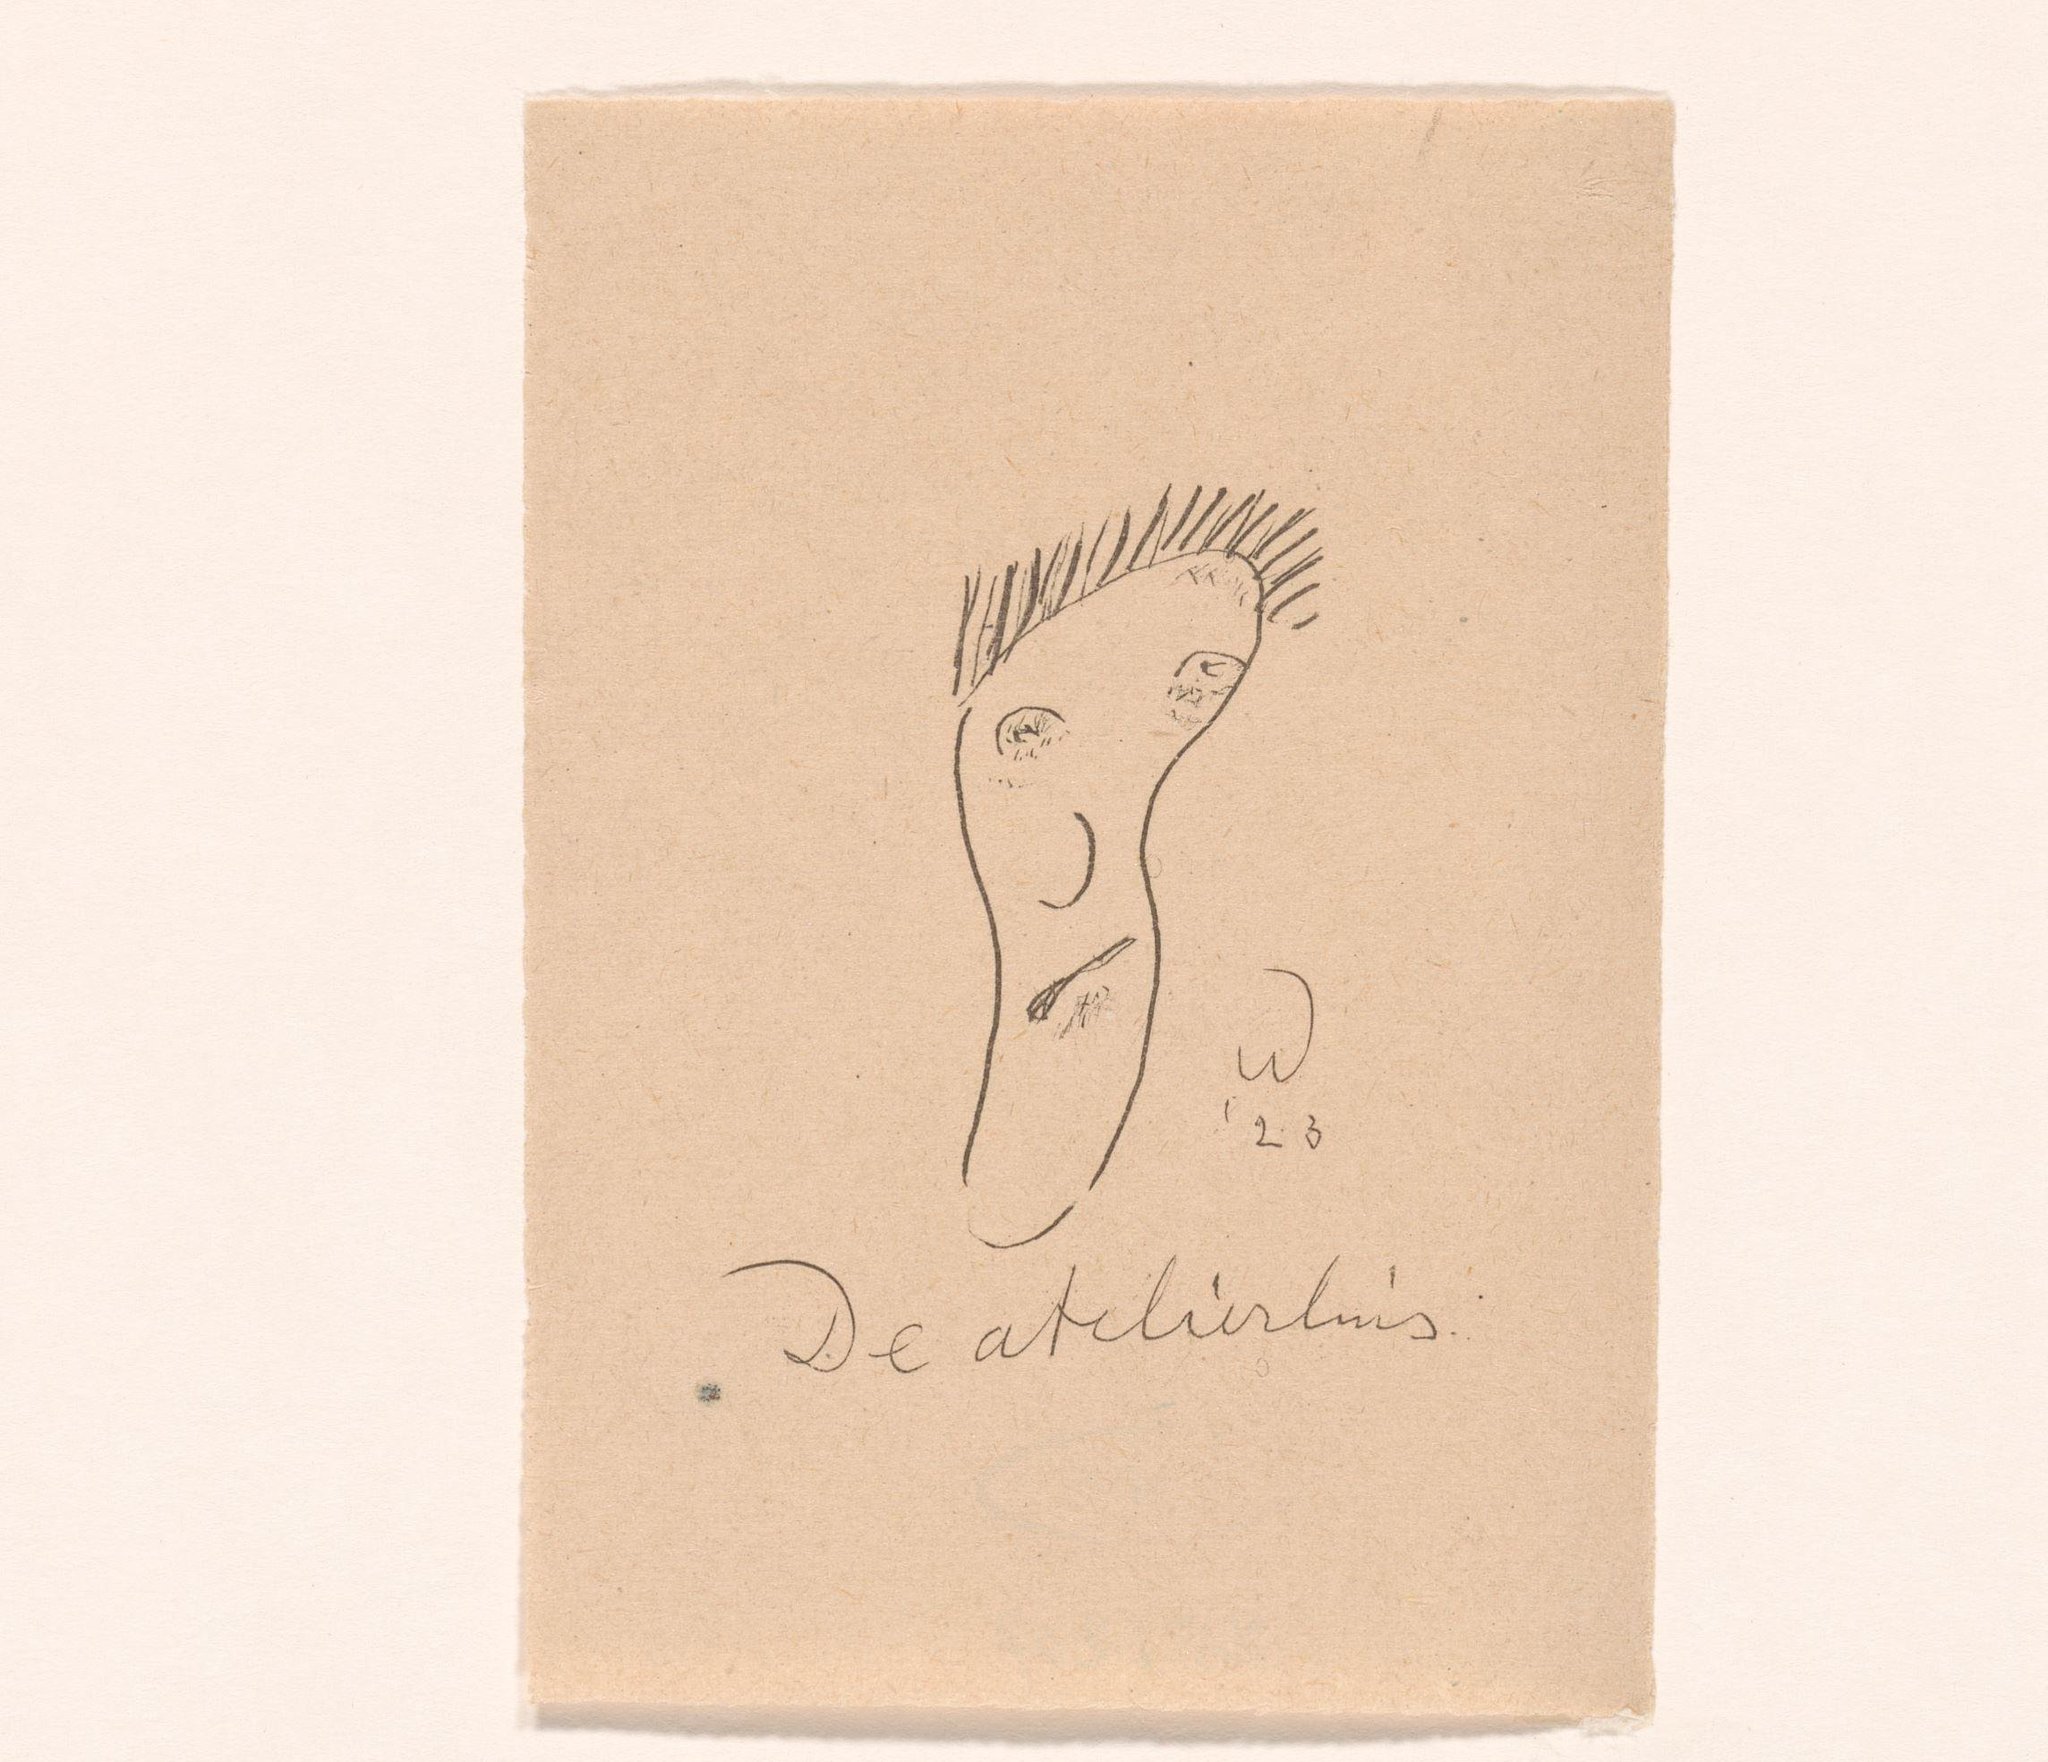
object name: print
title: Idealisten II en verdere Kanttekeningen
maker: erich wichmann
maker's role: print maker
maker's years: 1890-1929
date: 1923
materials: paper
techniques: lithograph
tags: caricatures (human types)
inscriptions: collector's mark: Lugt 2228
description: Langwerpig gezicht met omhoogstaand haar.